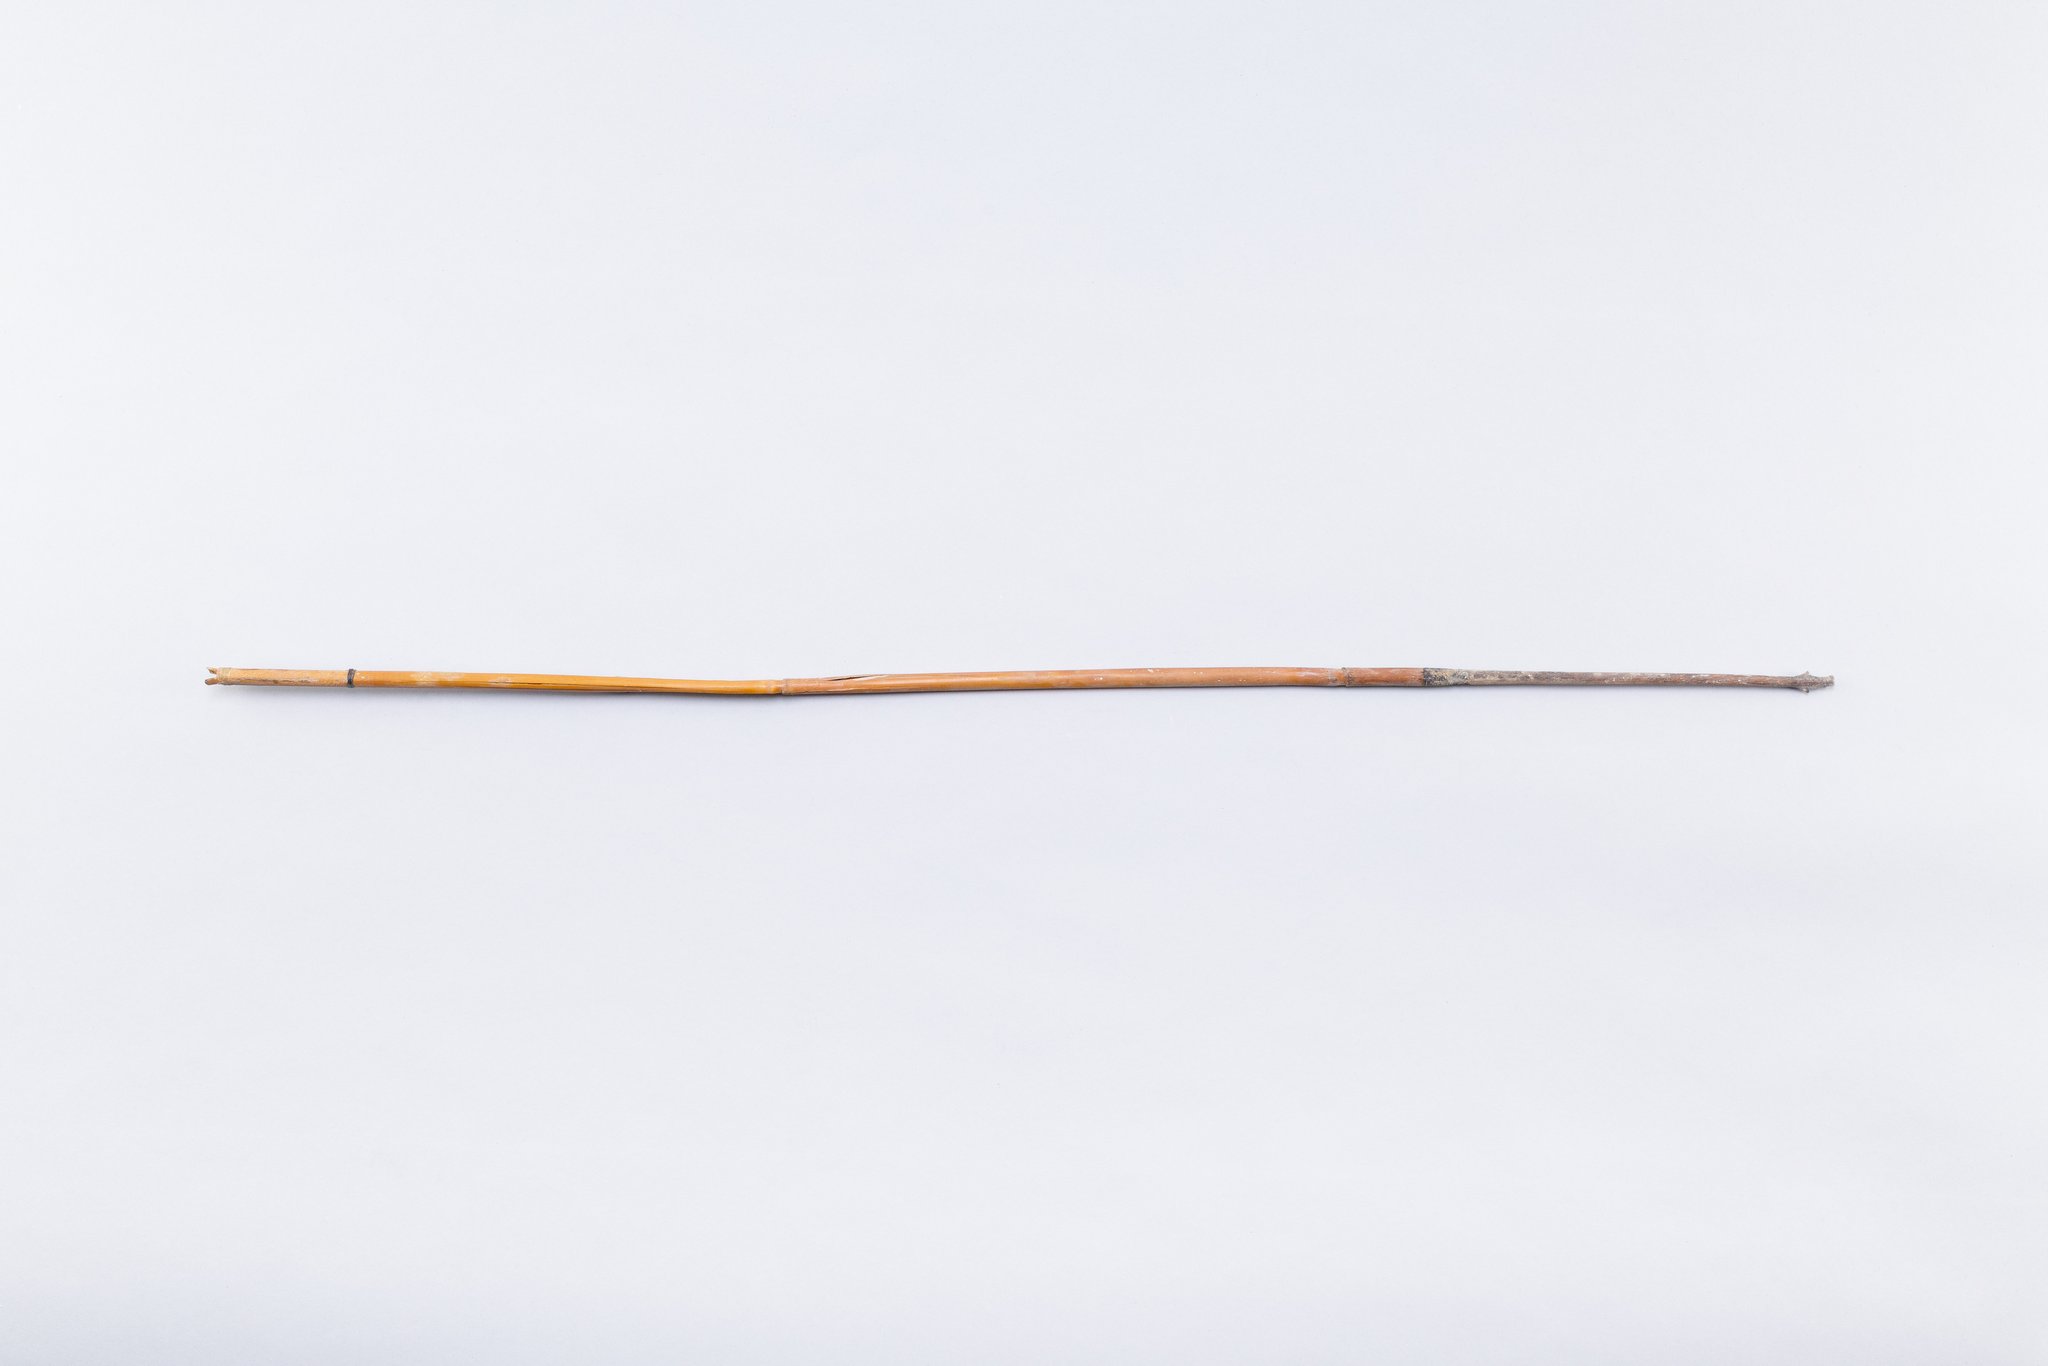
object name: arrow, arrowhead, adhesive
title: Arrow with composite stone tip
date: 1479-1458 BCE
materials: quartz, wood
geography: egypt